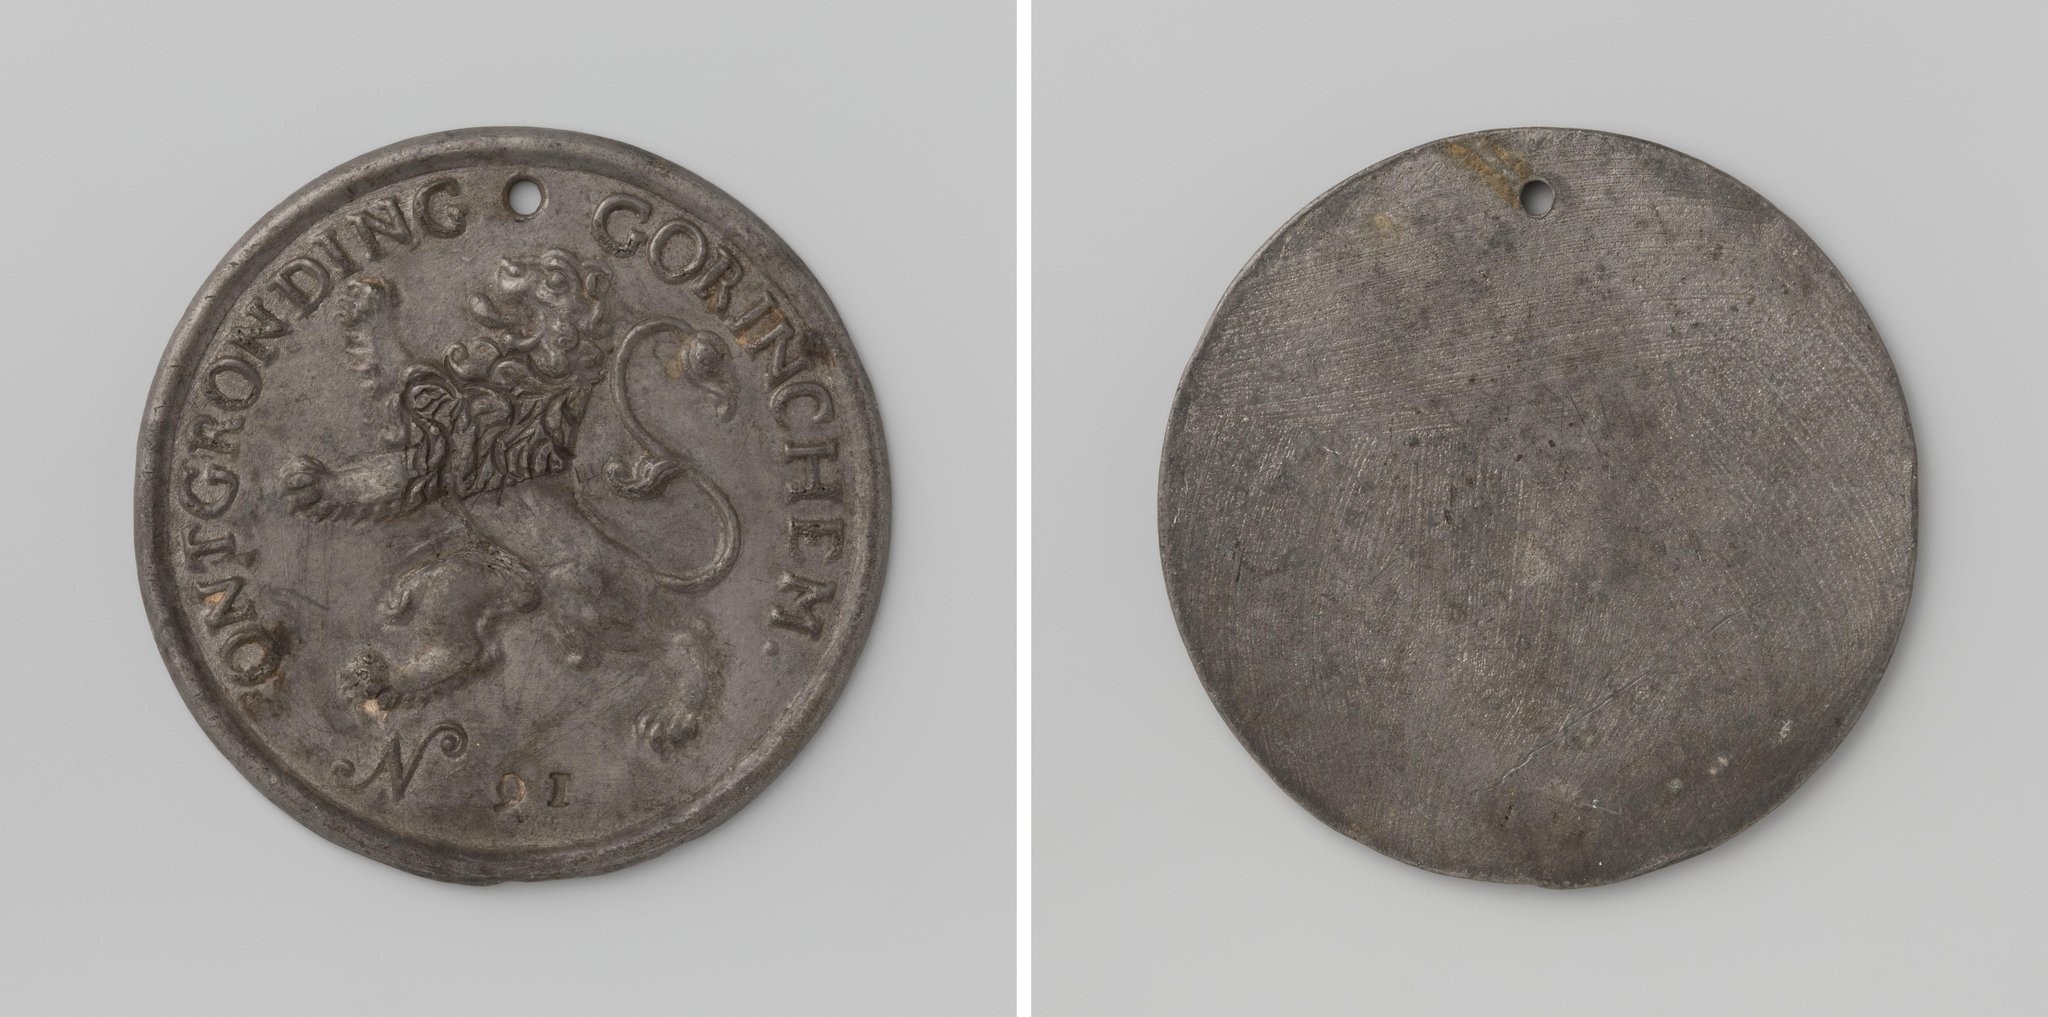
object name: identification medal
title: Ontgronding te Gorinchem, penning met no. 91, bewijs voor turfdragers, -vullers of -tonners om turf in te mogen steken uit de nieuw ontgronde venen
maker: Anonymous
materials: lead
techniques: casting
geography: gorinchem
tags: gorinchem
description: Eenzijdige loden penning met gat erin. Voorzijde: staande leeuw binnen omschrift, boven cijfer N 91. Keerzijde: blanco.